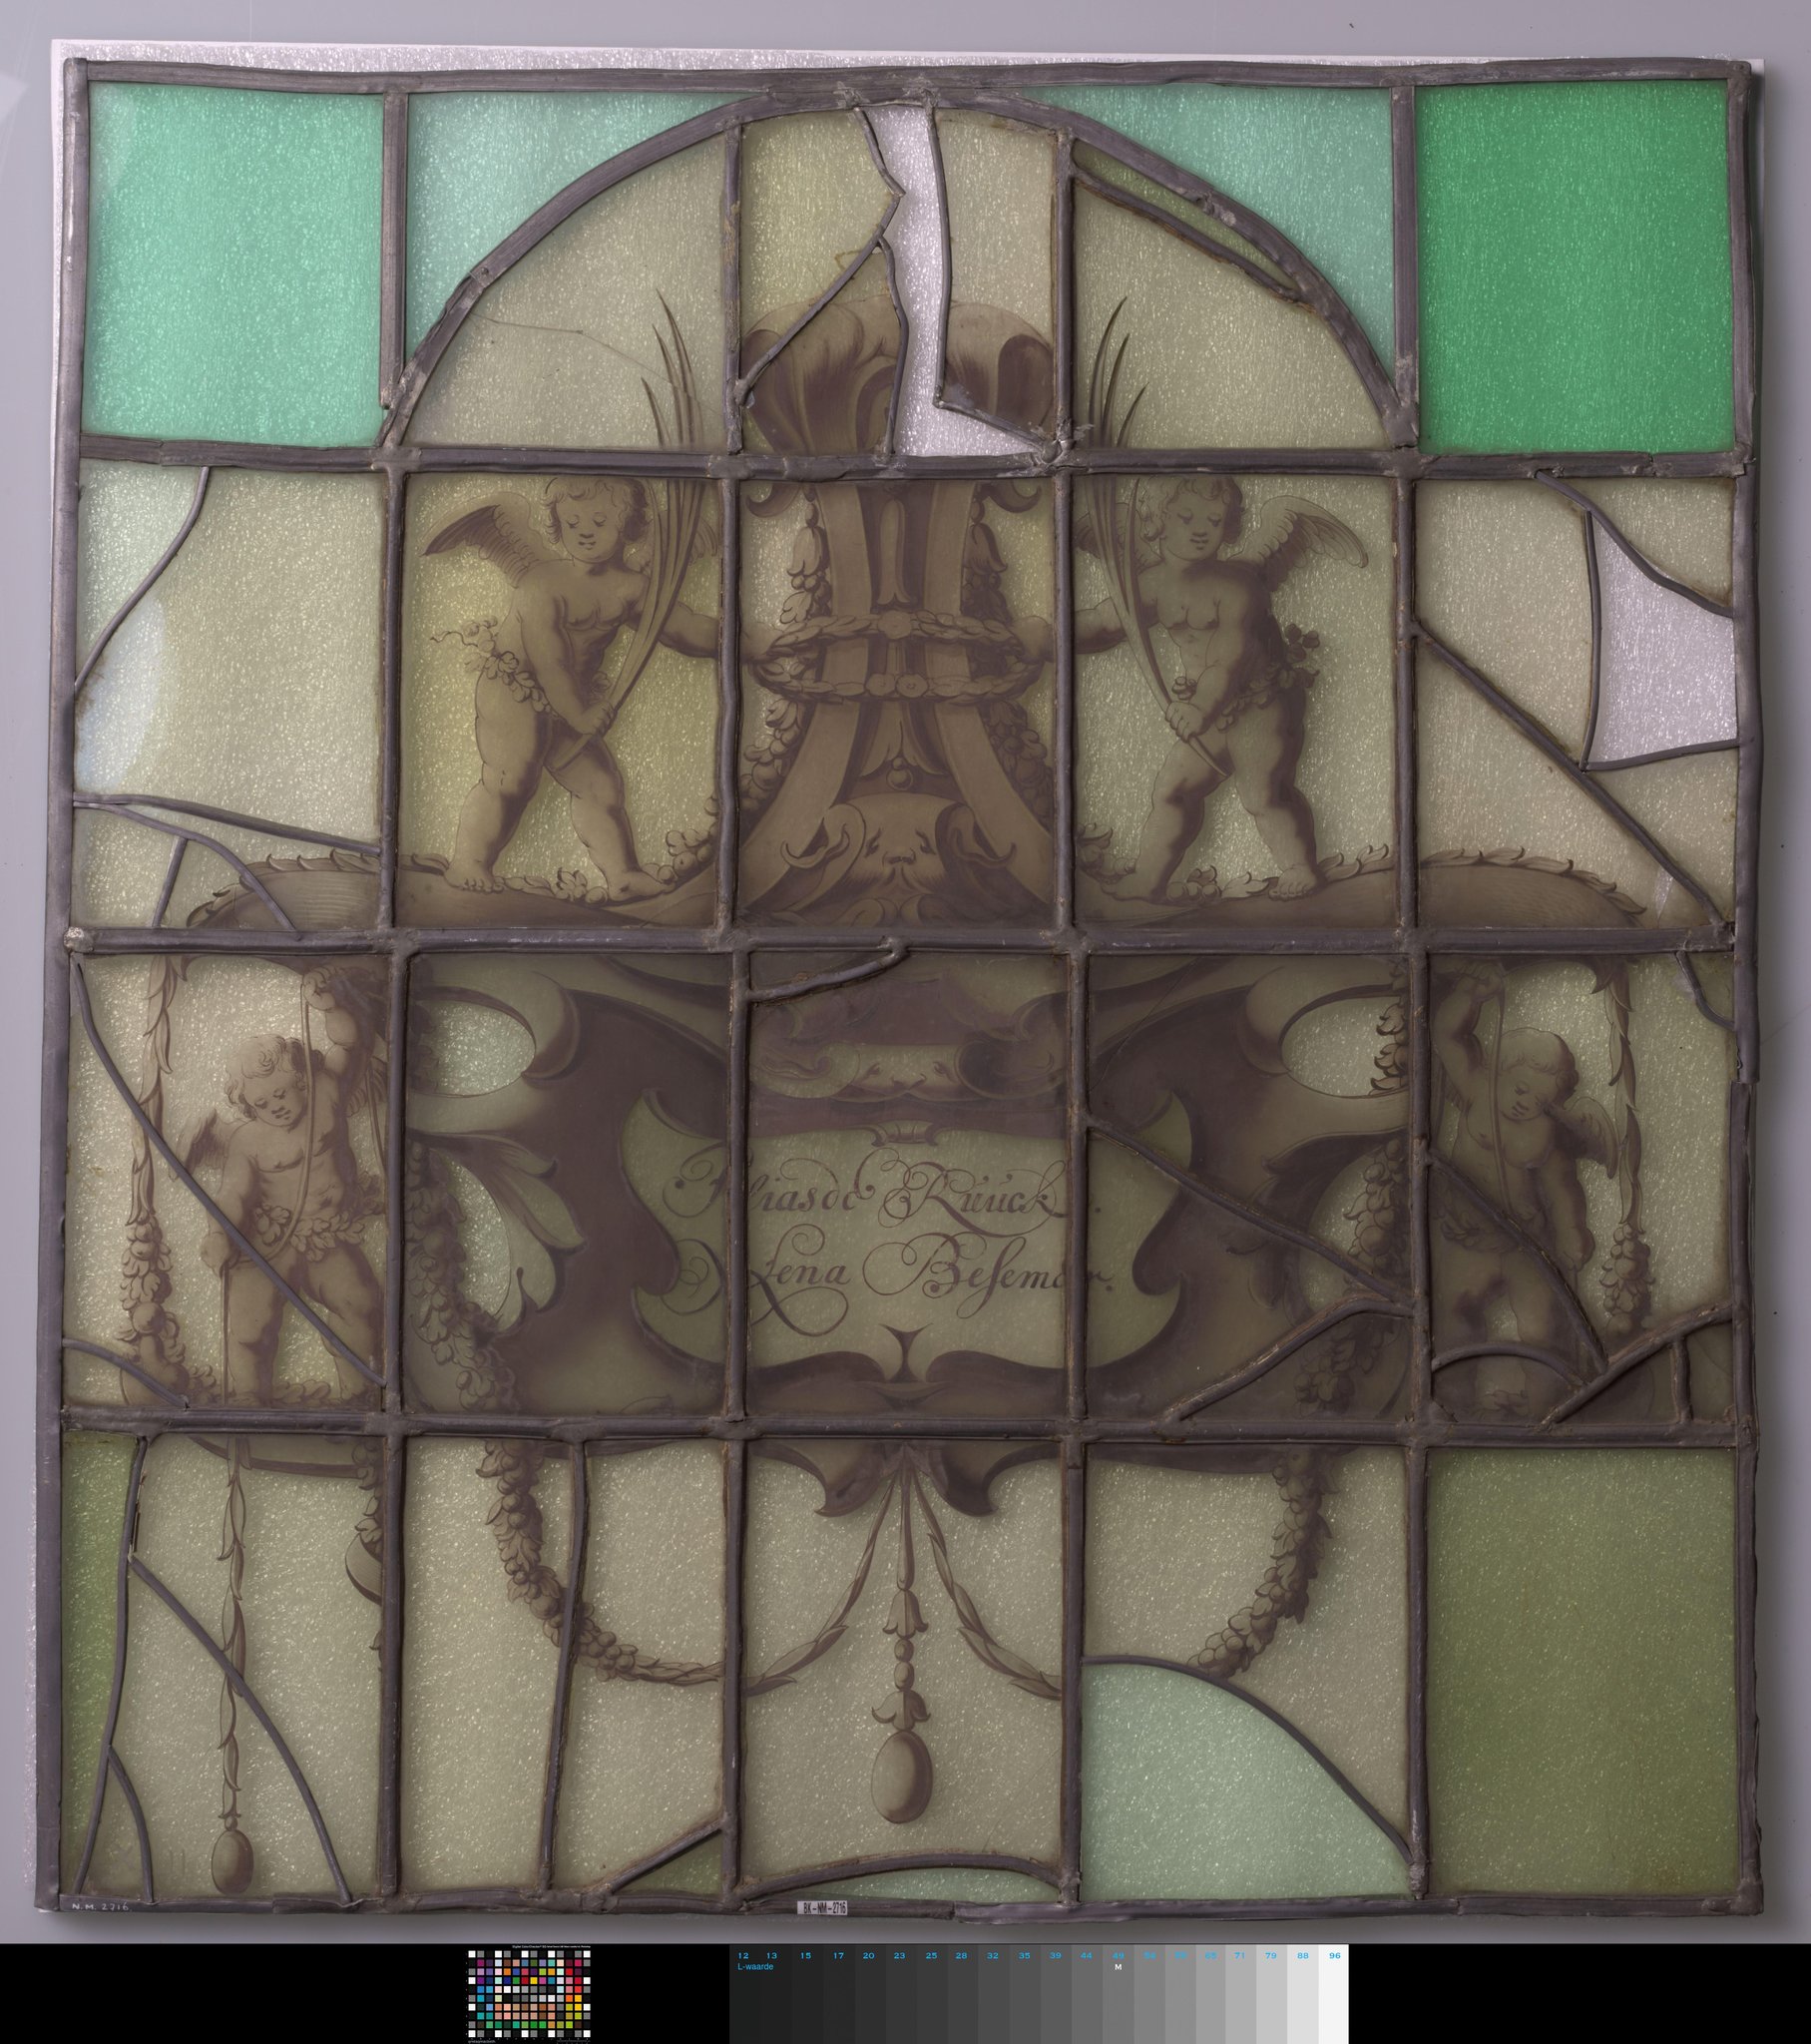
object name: light window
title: Ruit met cartouche met engeltjes en inscriptie "Lias Ruuck, Lena Besemer"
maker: Anonymous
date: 1600-1699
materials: glass, lead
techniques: leading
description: Raam bestaande uit zeventien ruitjes in grisaille met ornament en engeltjes. In cartouche o.a. "Lena Besemer". Opmerking: Soortgelijke ruit als inv. nr. BK-NM-2715.